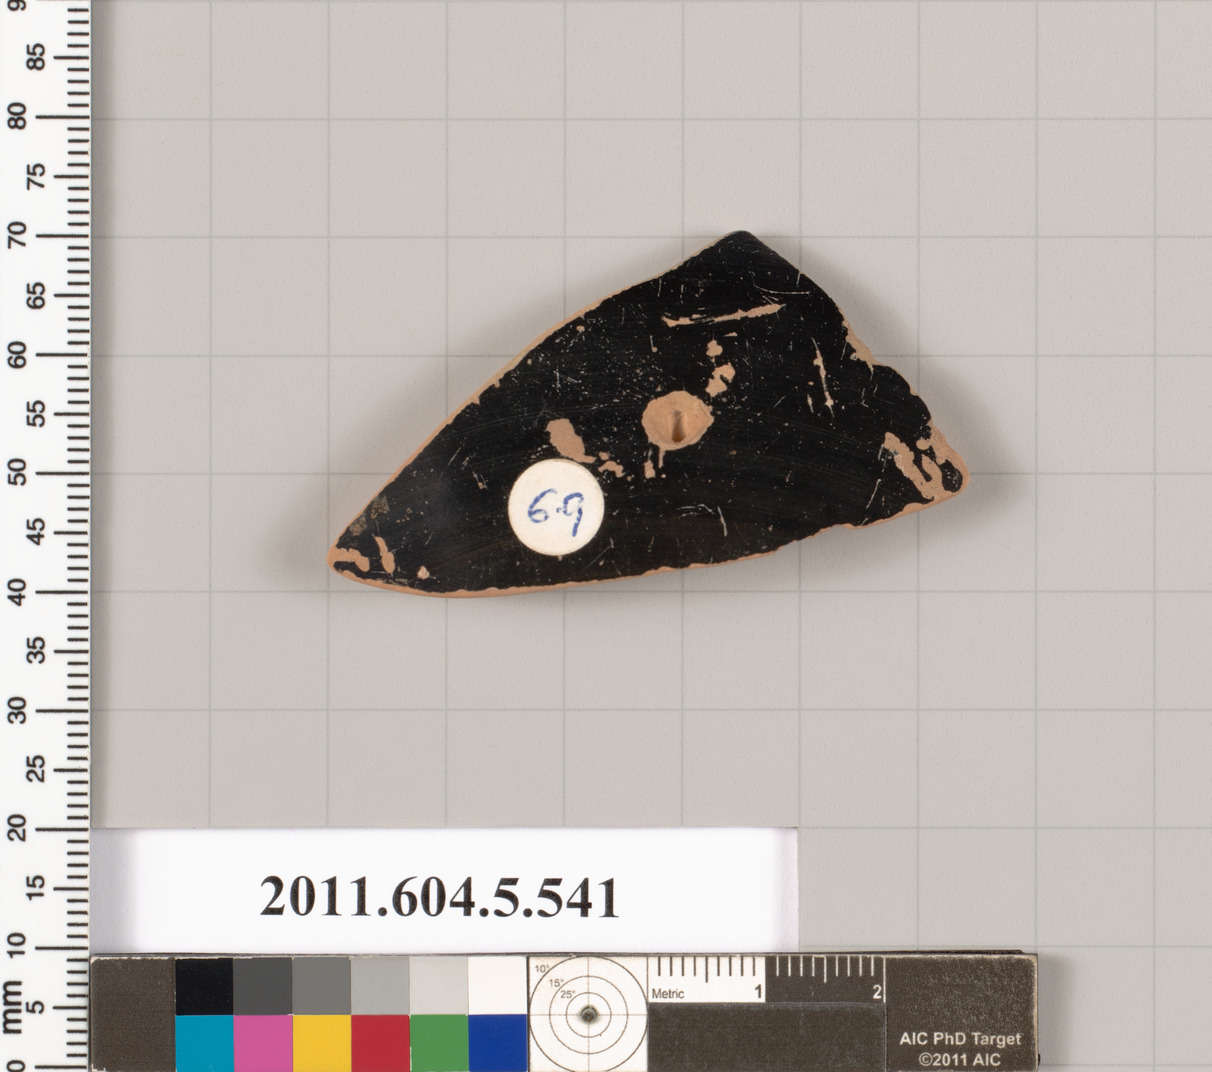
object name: kylix fragment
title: Terracotta fragment of a kylix (drinking cup)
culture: greek, attic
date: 600-401 BCE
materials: terracotta